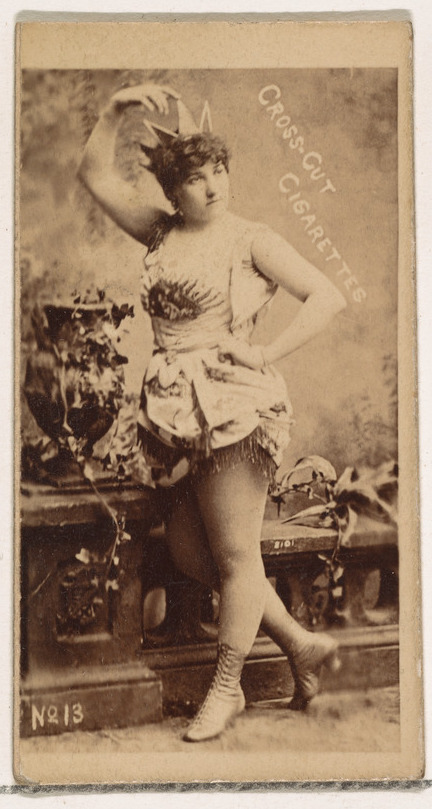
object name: print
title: Card Number 13, from the Actors and Actresses series (N145-1) issued by Duke Sons & Co. to promote Cross Cut Cigarettes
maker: w. duke, sons & co.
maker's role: publisher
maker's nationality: american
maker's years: 1870-1920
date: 1880-1889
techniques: albumen silver print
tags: portraits,women,actresses